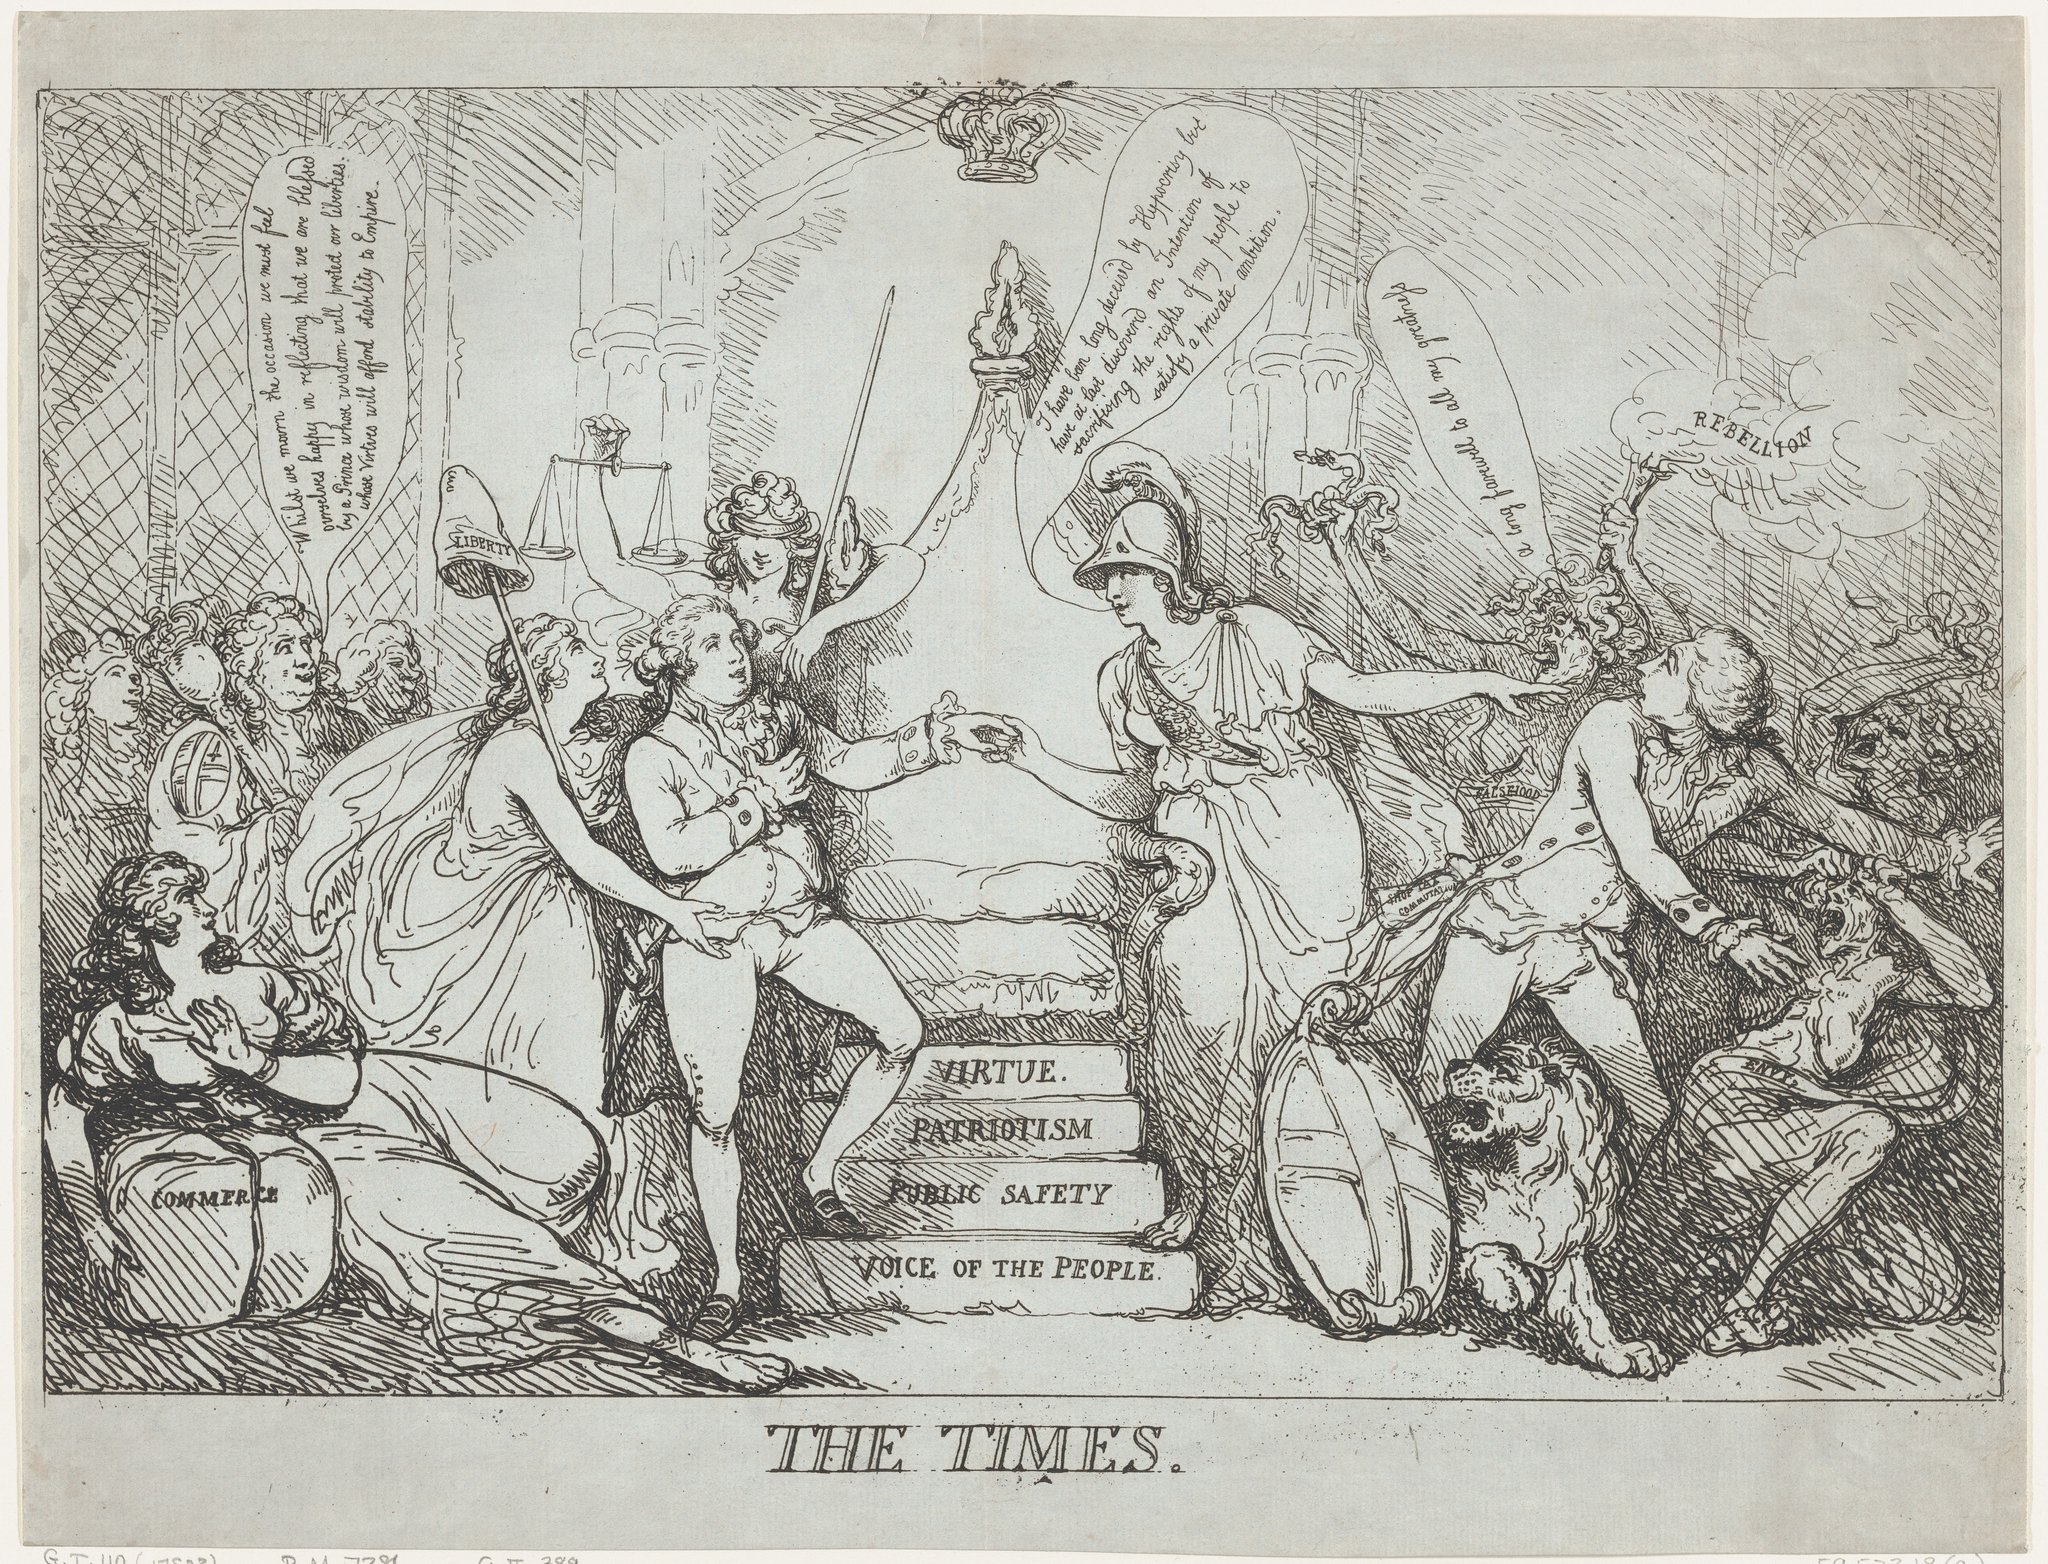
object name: print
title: The Times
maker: thomas rowlandson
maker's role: artist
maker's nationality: british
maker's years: 1757-1827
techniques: etching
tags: satire,men,women,politics